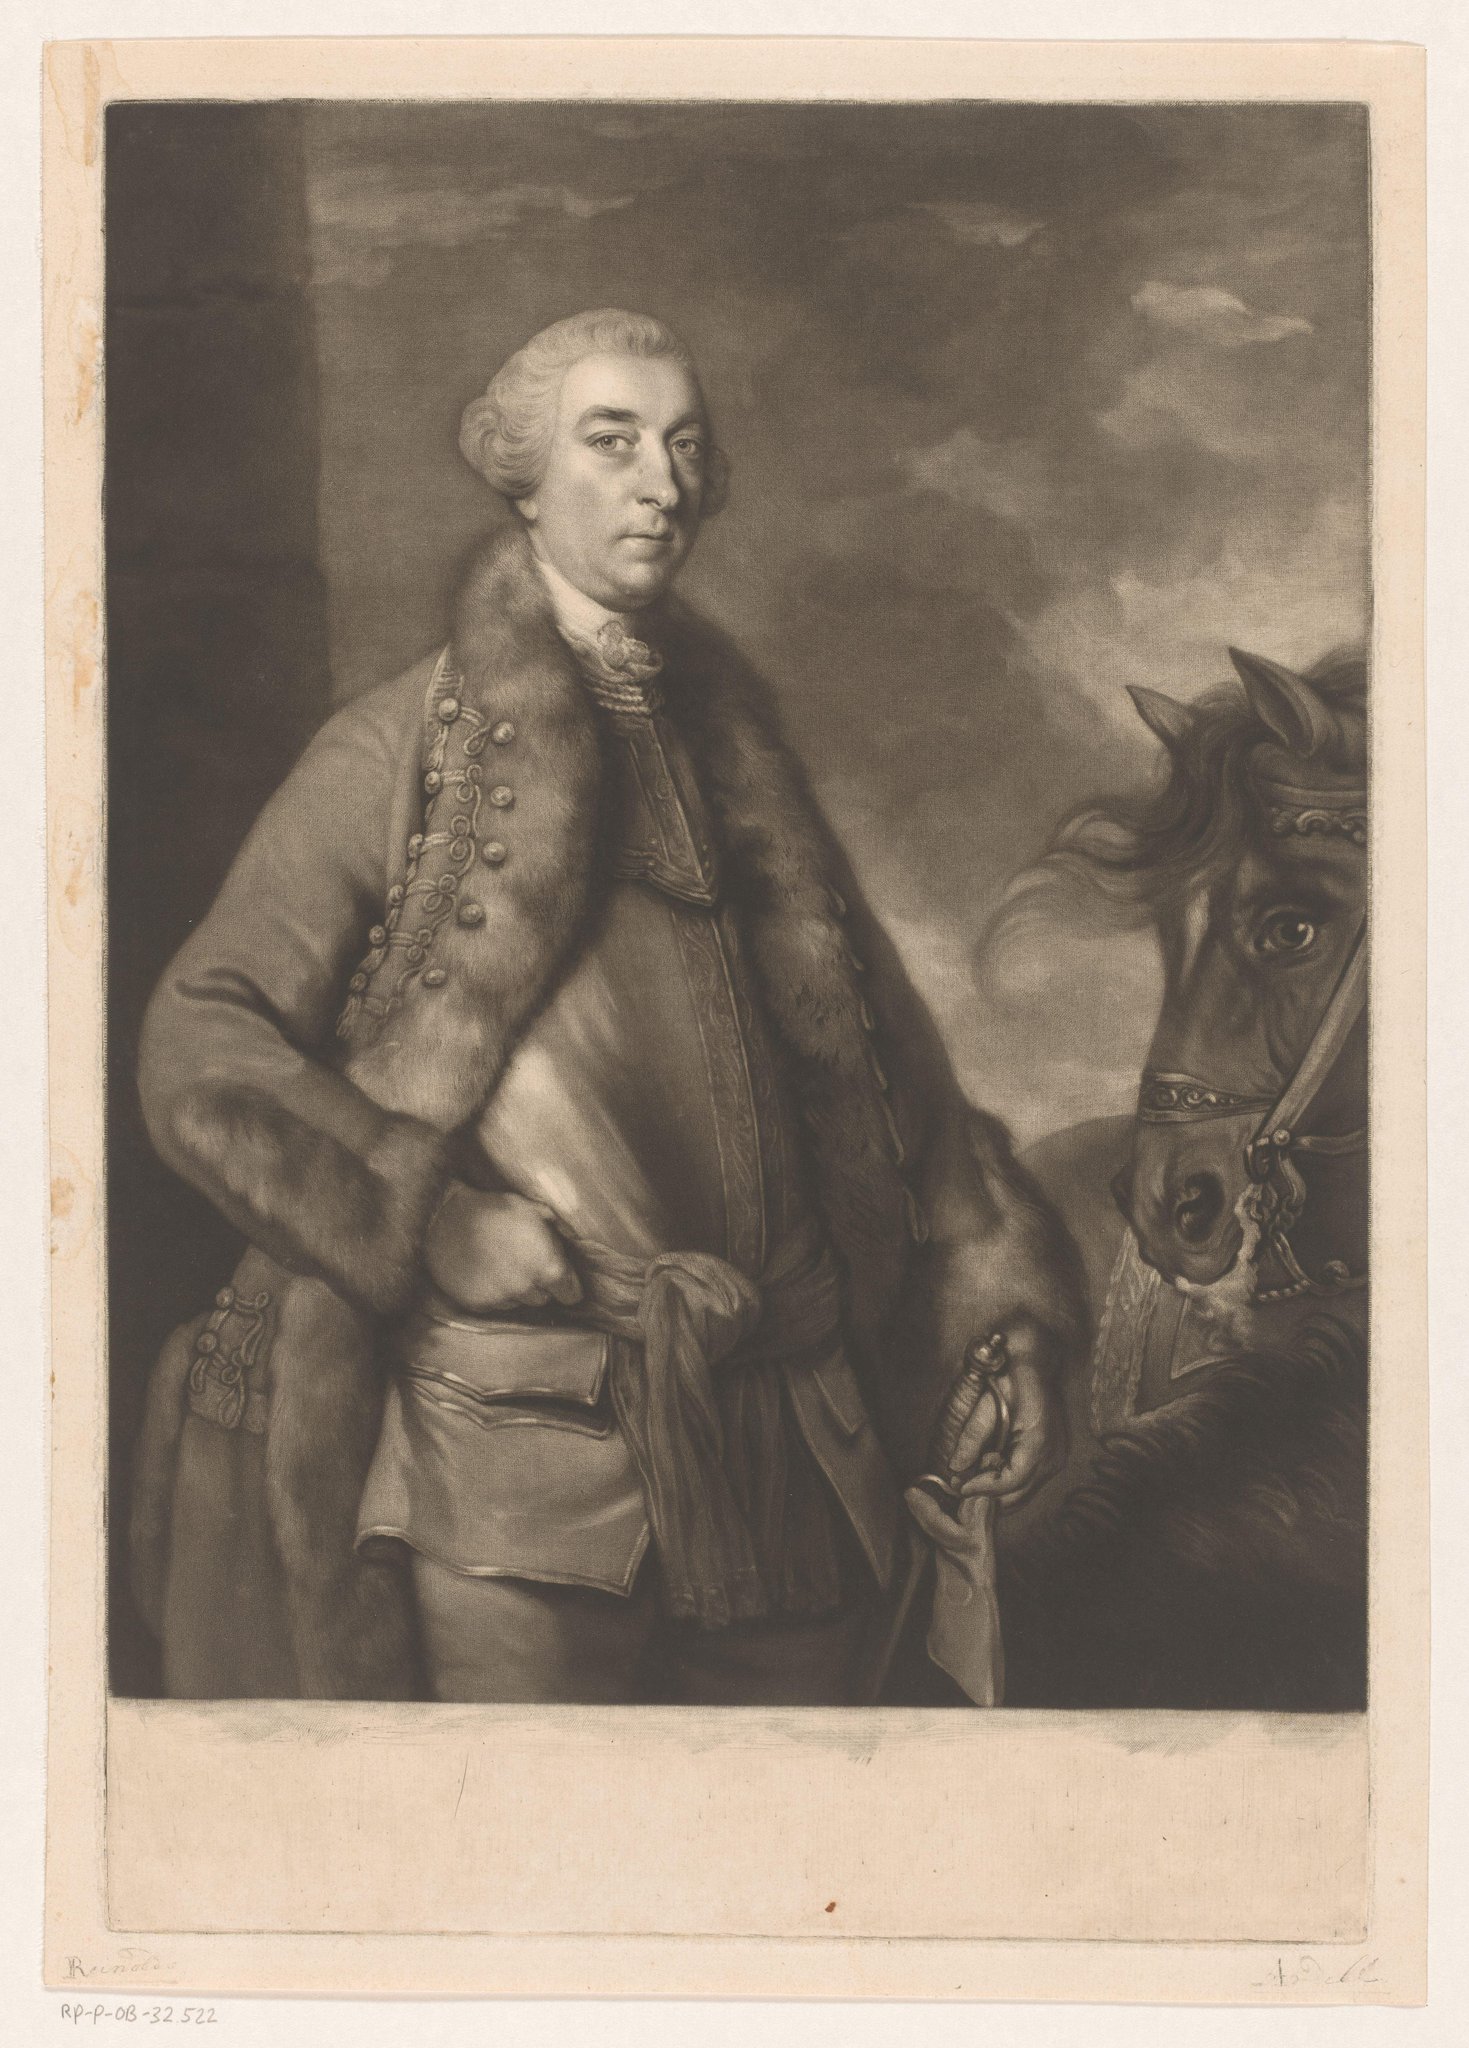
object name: print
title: Portret van George Germain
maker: james mcardell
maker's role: print maker, publisher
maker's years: 1728-1765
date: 1759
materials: paper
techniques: mezzotint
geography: london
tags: politician, historical persons, politician, e.g. party leader, horse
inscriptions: collector's mark: Lugt 240